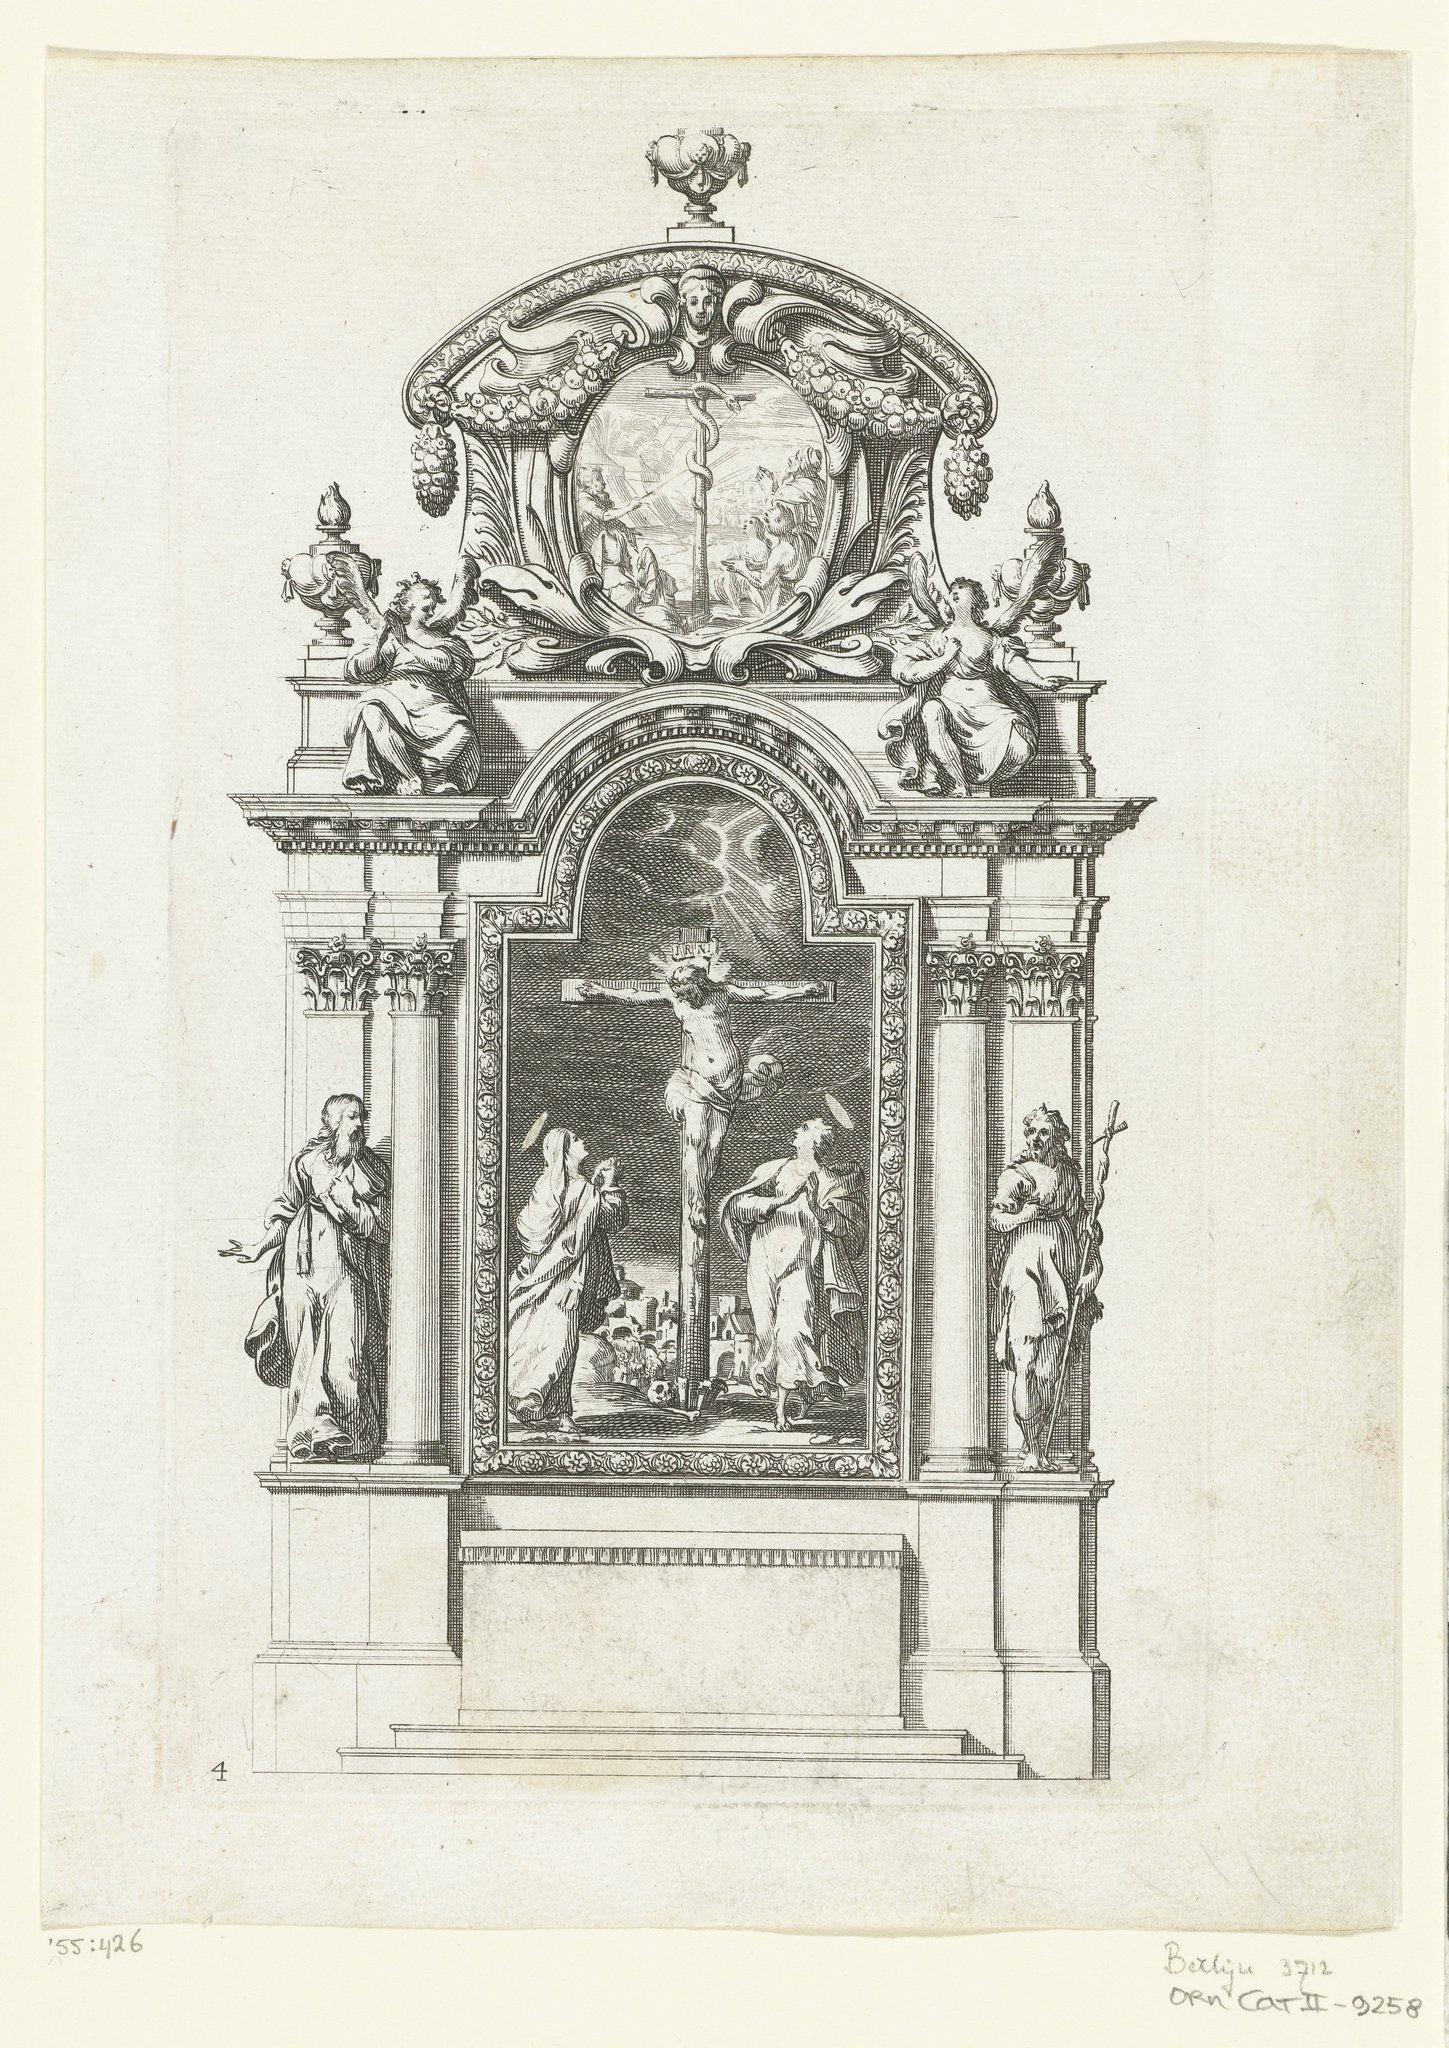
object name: ornament print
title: Livre d' Architecture et d' Autels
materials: paper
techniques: etching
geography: france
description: Aan weerszijden van Christus staan Maria en Johannes. Blad 4 uit tweede uitgave van serie.